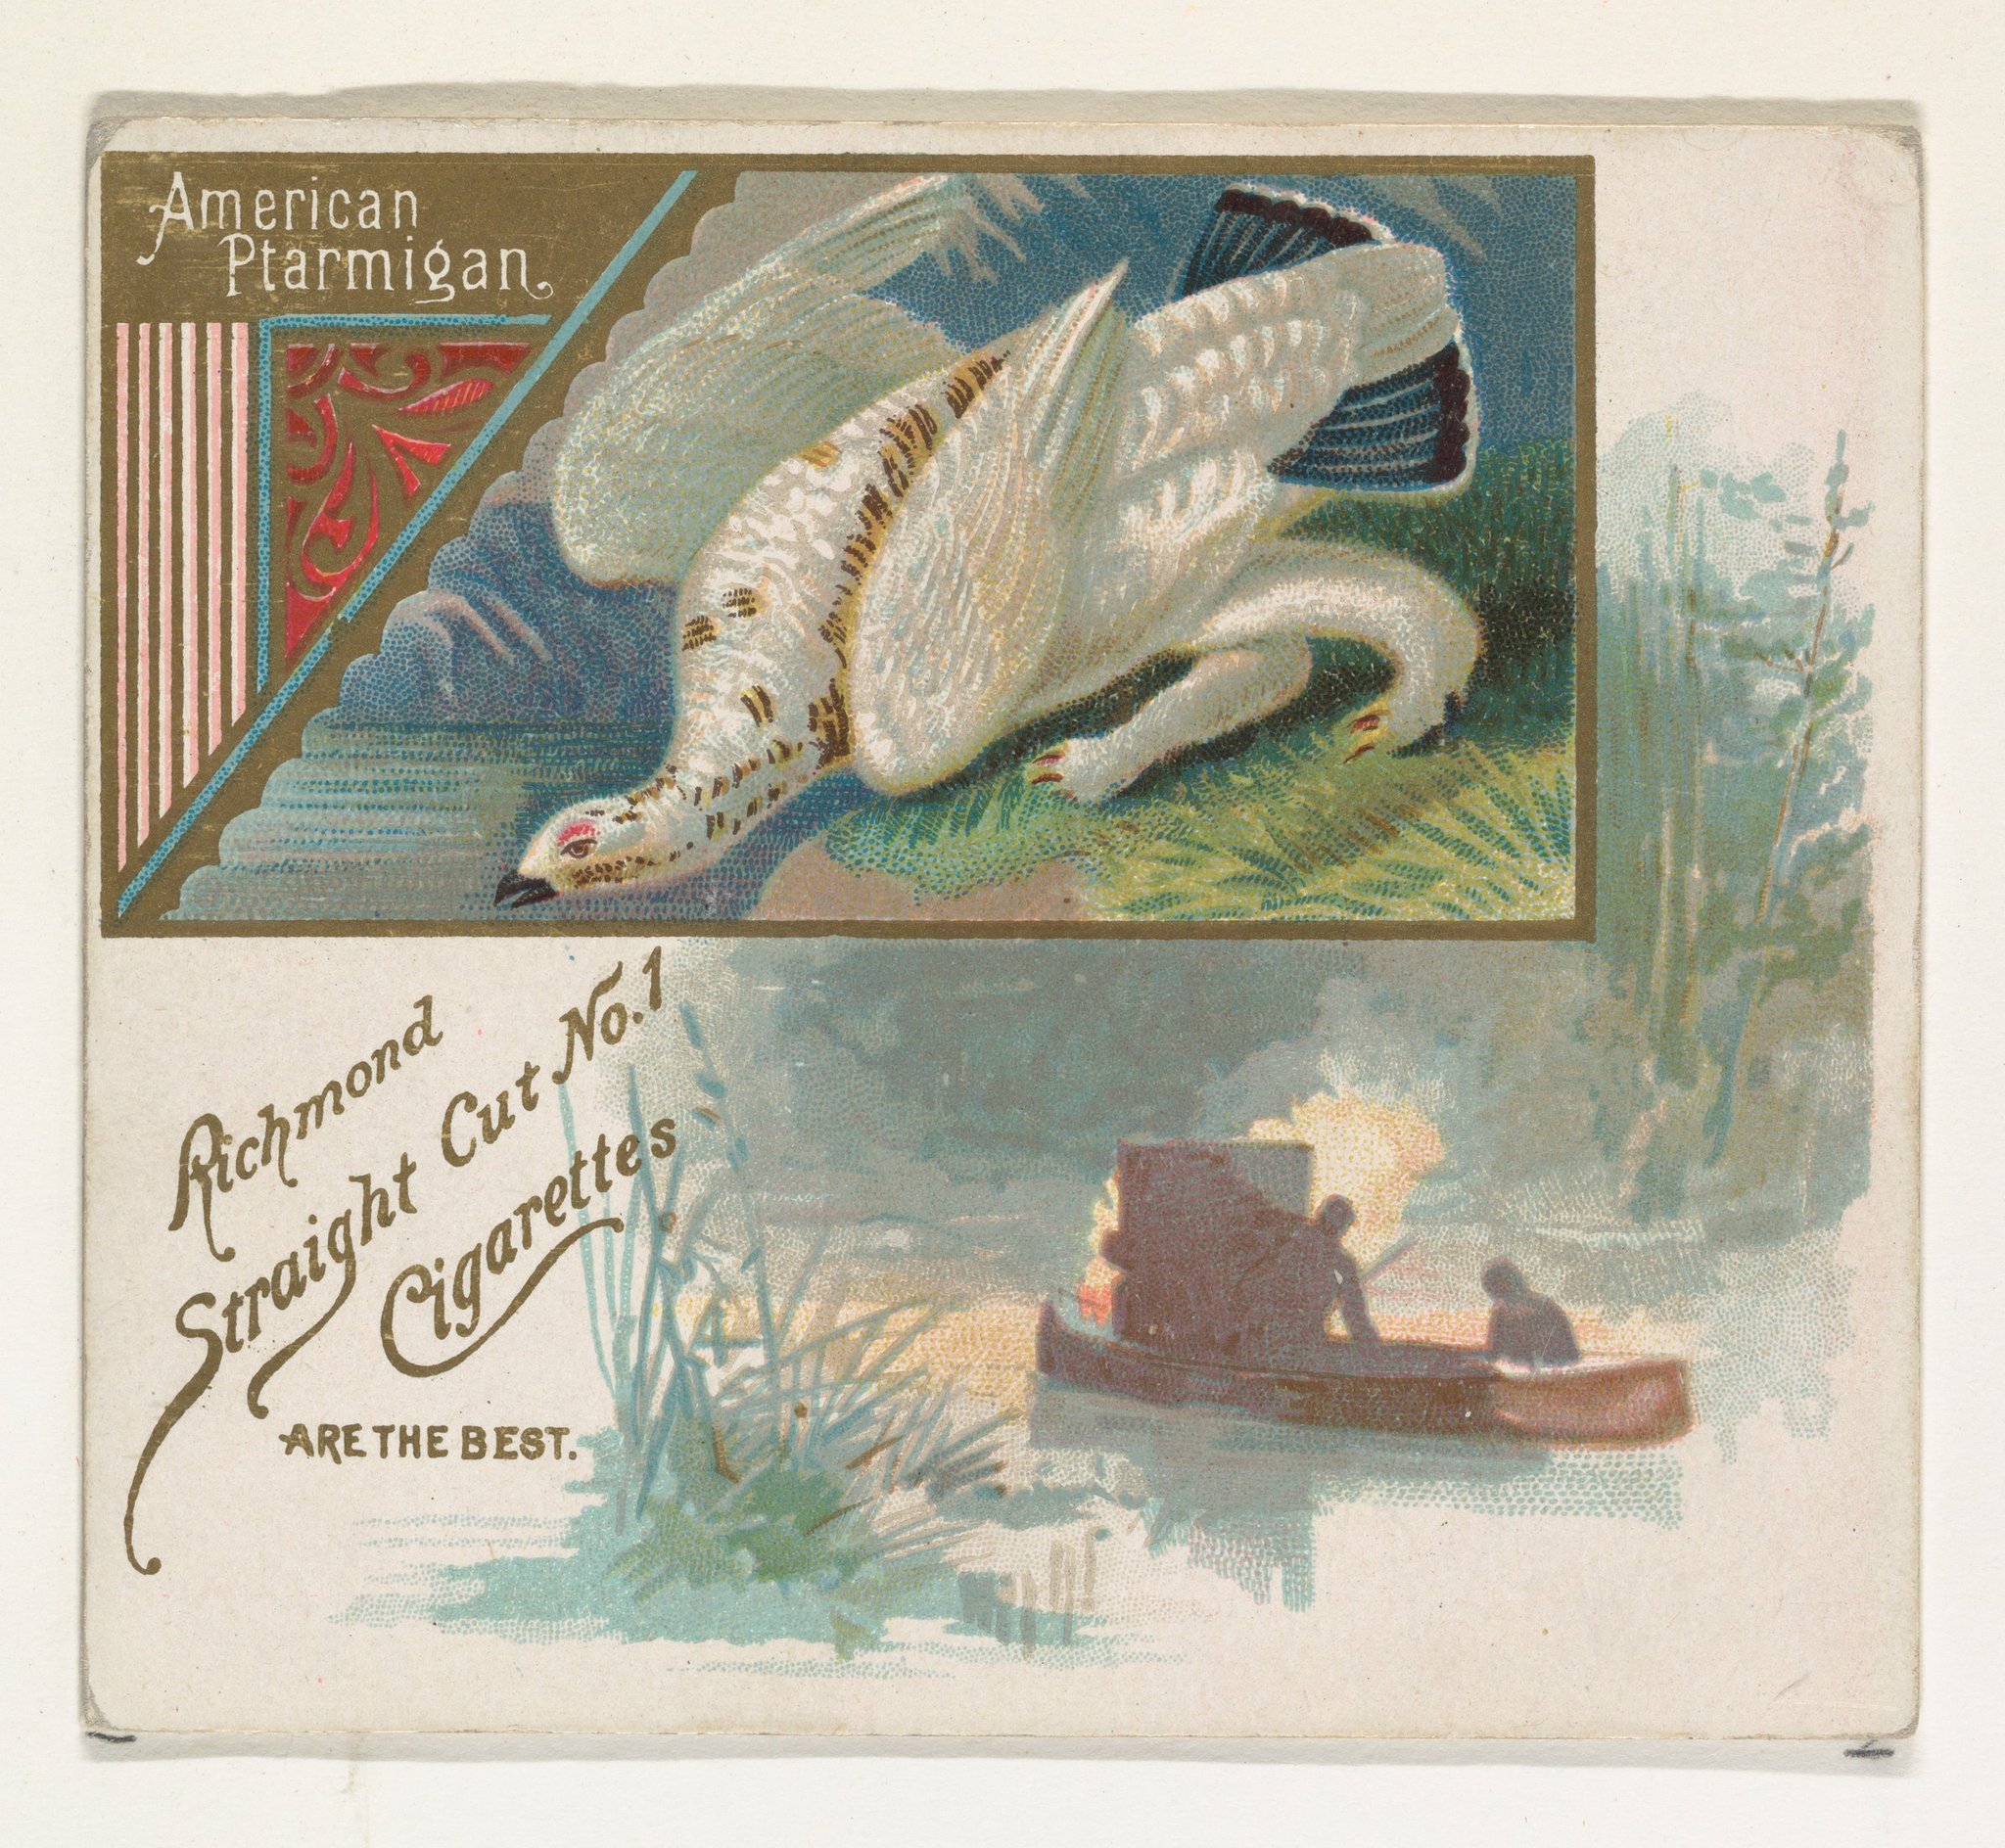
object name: print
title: American Ptarmigan, from the Game Birds series (N40) for Allen & Ginter Cigarettes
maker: allen & ginter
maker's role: publisher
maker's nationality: american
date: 1888-1890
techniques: color lithograph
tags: birds,boats